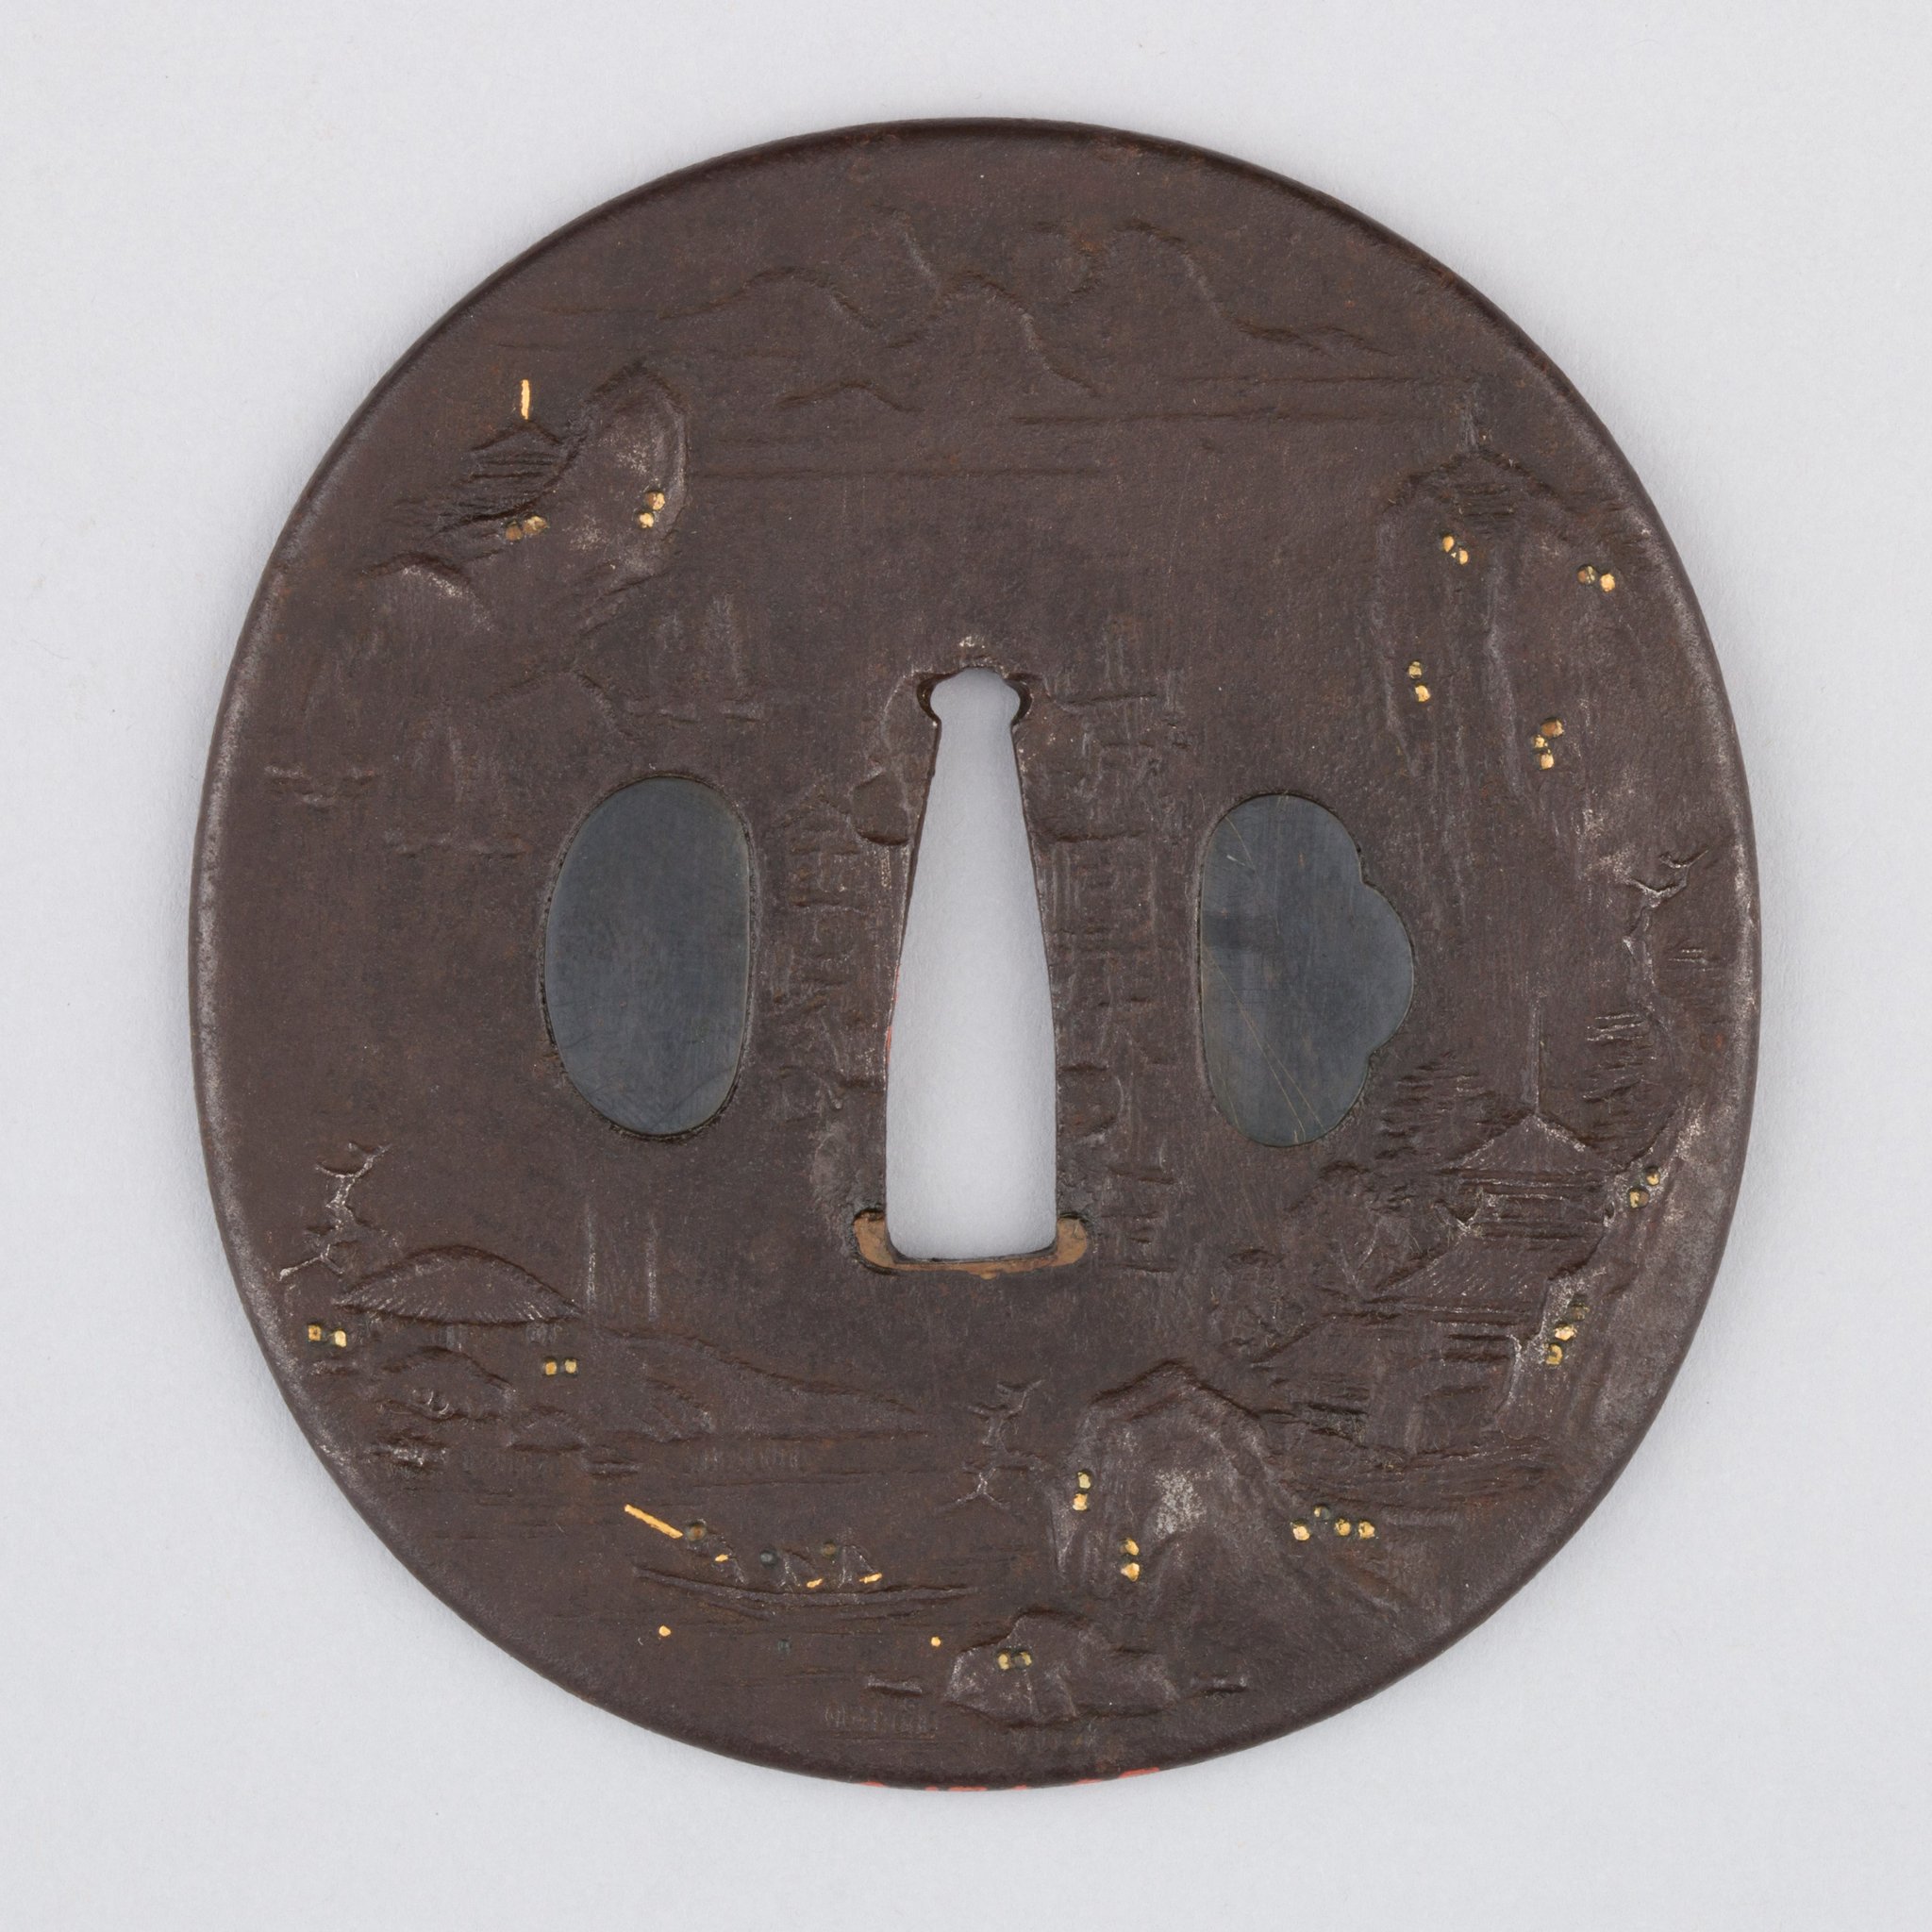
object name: sword guard tsuba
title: Sword Guard (Tsuba)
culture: japanese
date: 1615-1868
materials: copper, iron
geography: japan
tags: landscapes